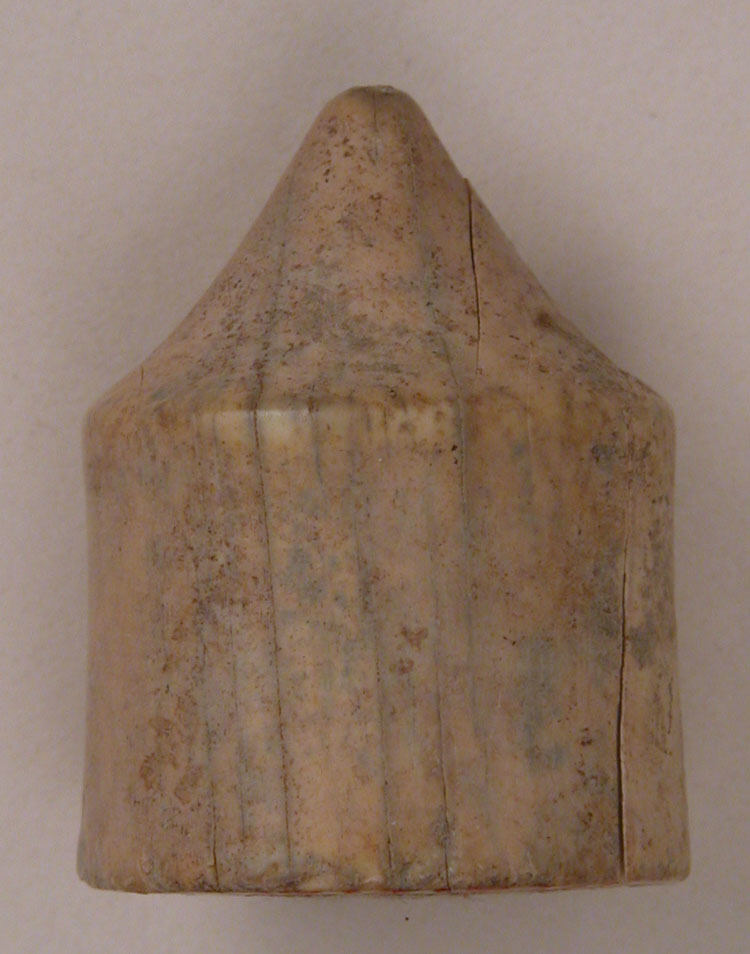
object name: chess piece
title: Chess Piece, Pawn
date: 801-1100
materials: ivory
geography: western islamic lands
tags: chess